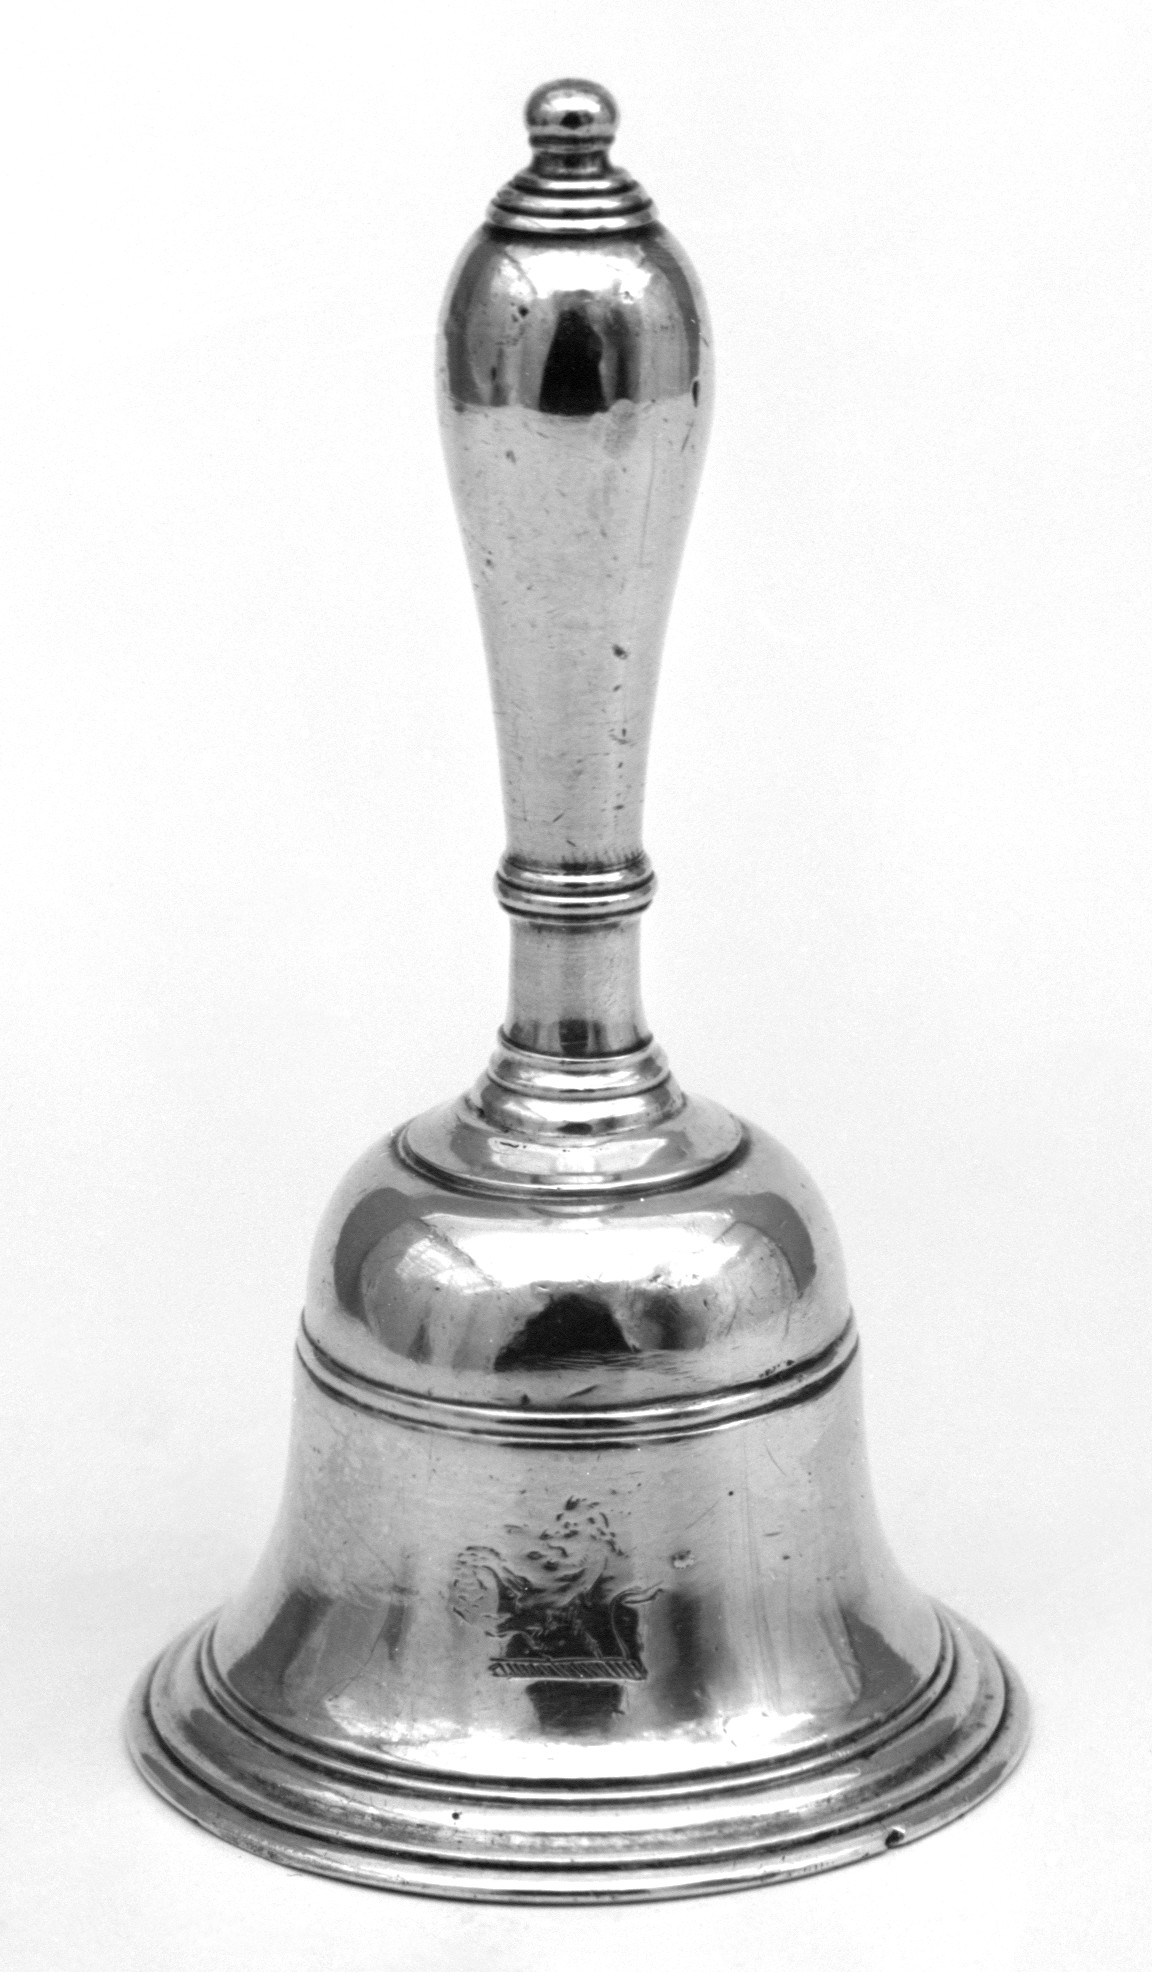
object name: bell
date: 1775-1776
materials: silver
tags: musical instruments,lions